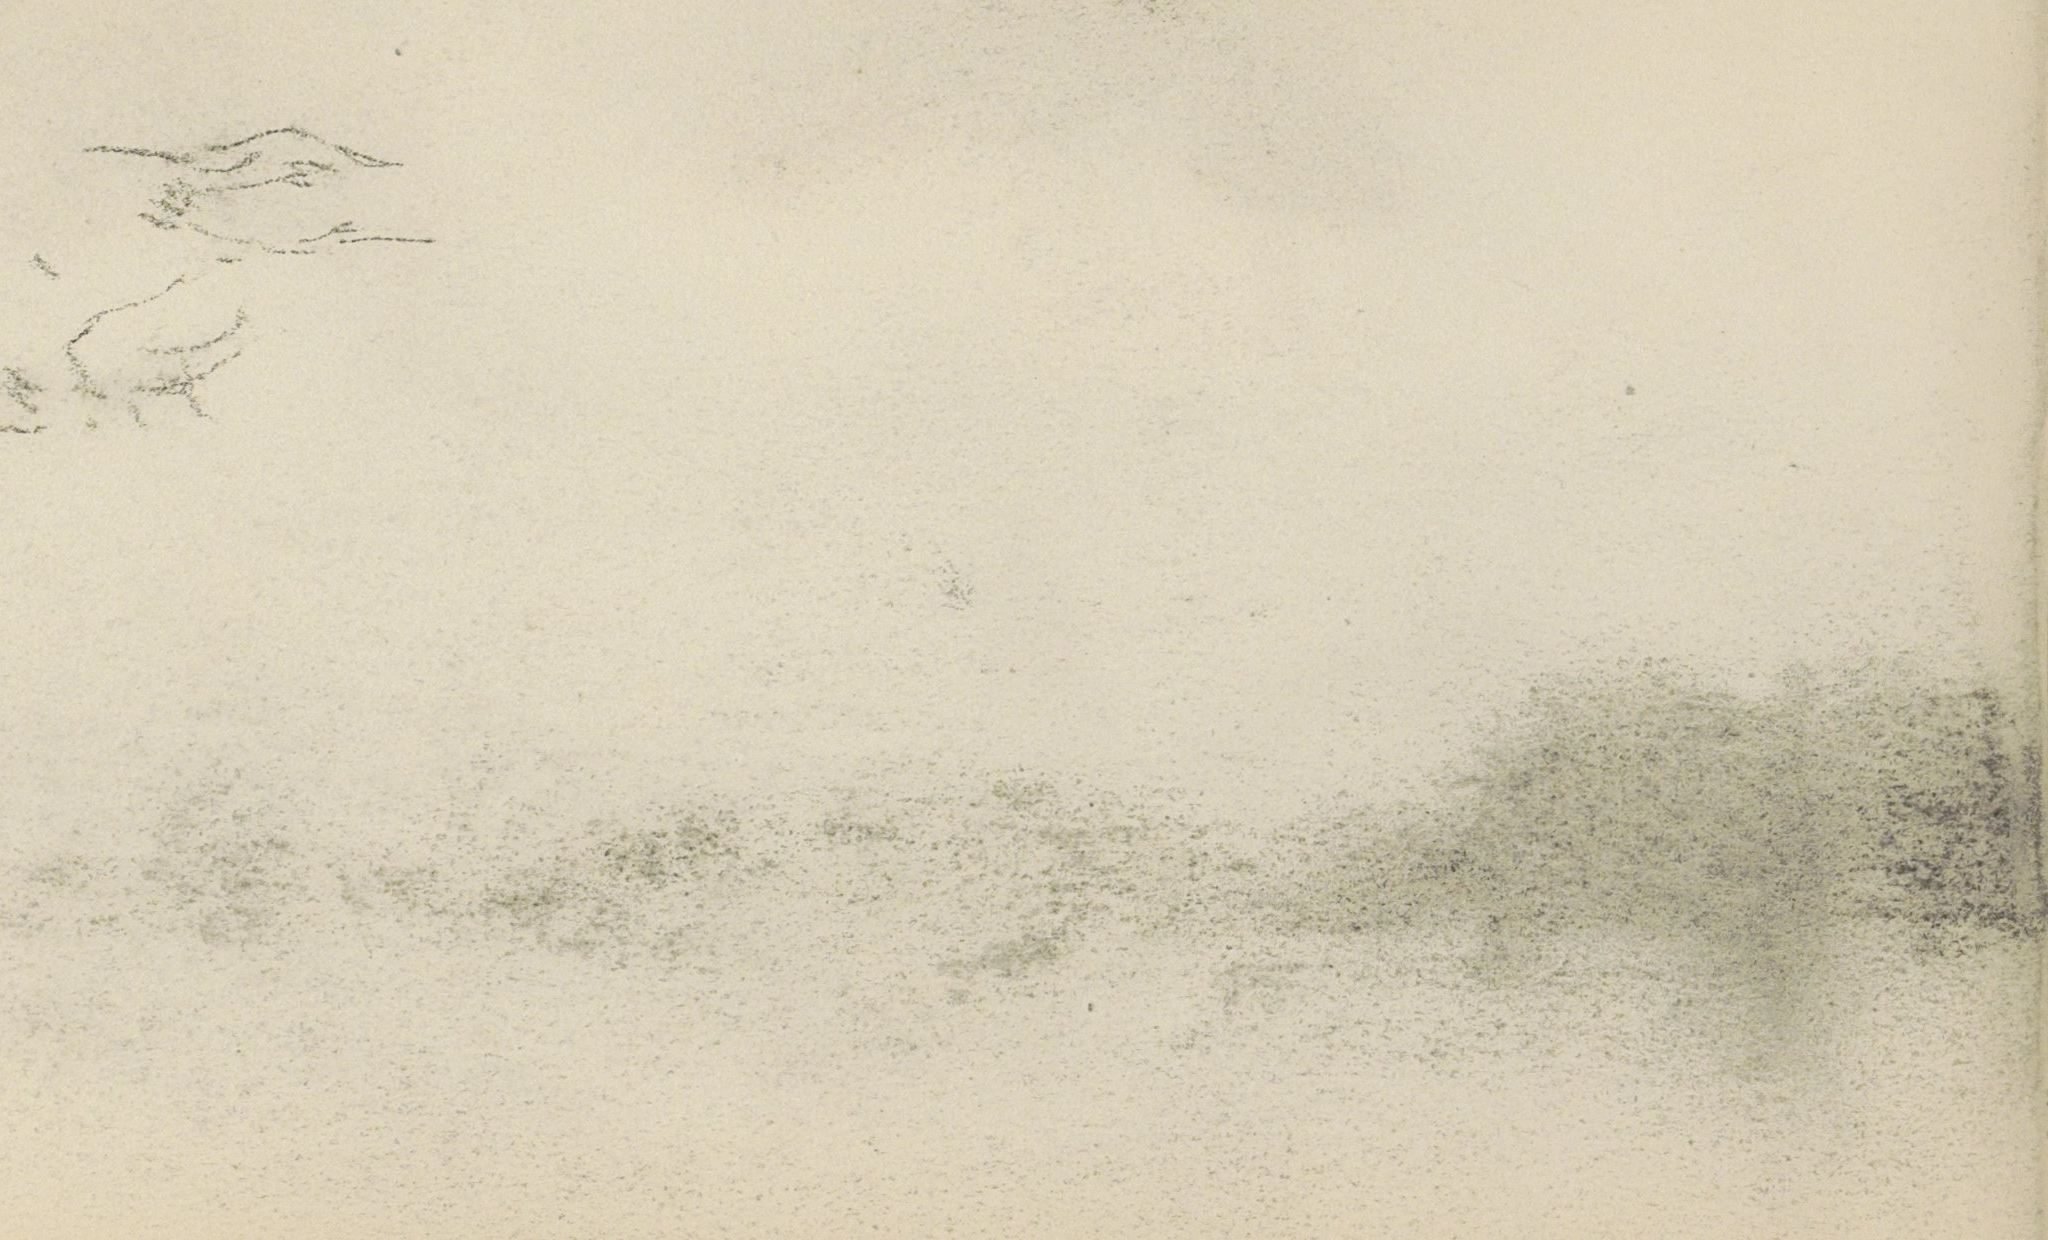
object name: sketchbook leaf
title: Studie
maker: johan antonie de jonge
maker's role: draughtsman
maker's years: 1864-1927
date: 1901-1927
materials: chalk, paper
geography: south holland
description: Studie. Blad 15 verso uit een schetsboek met 45 bladen.